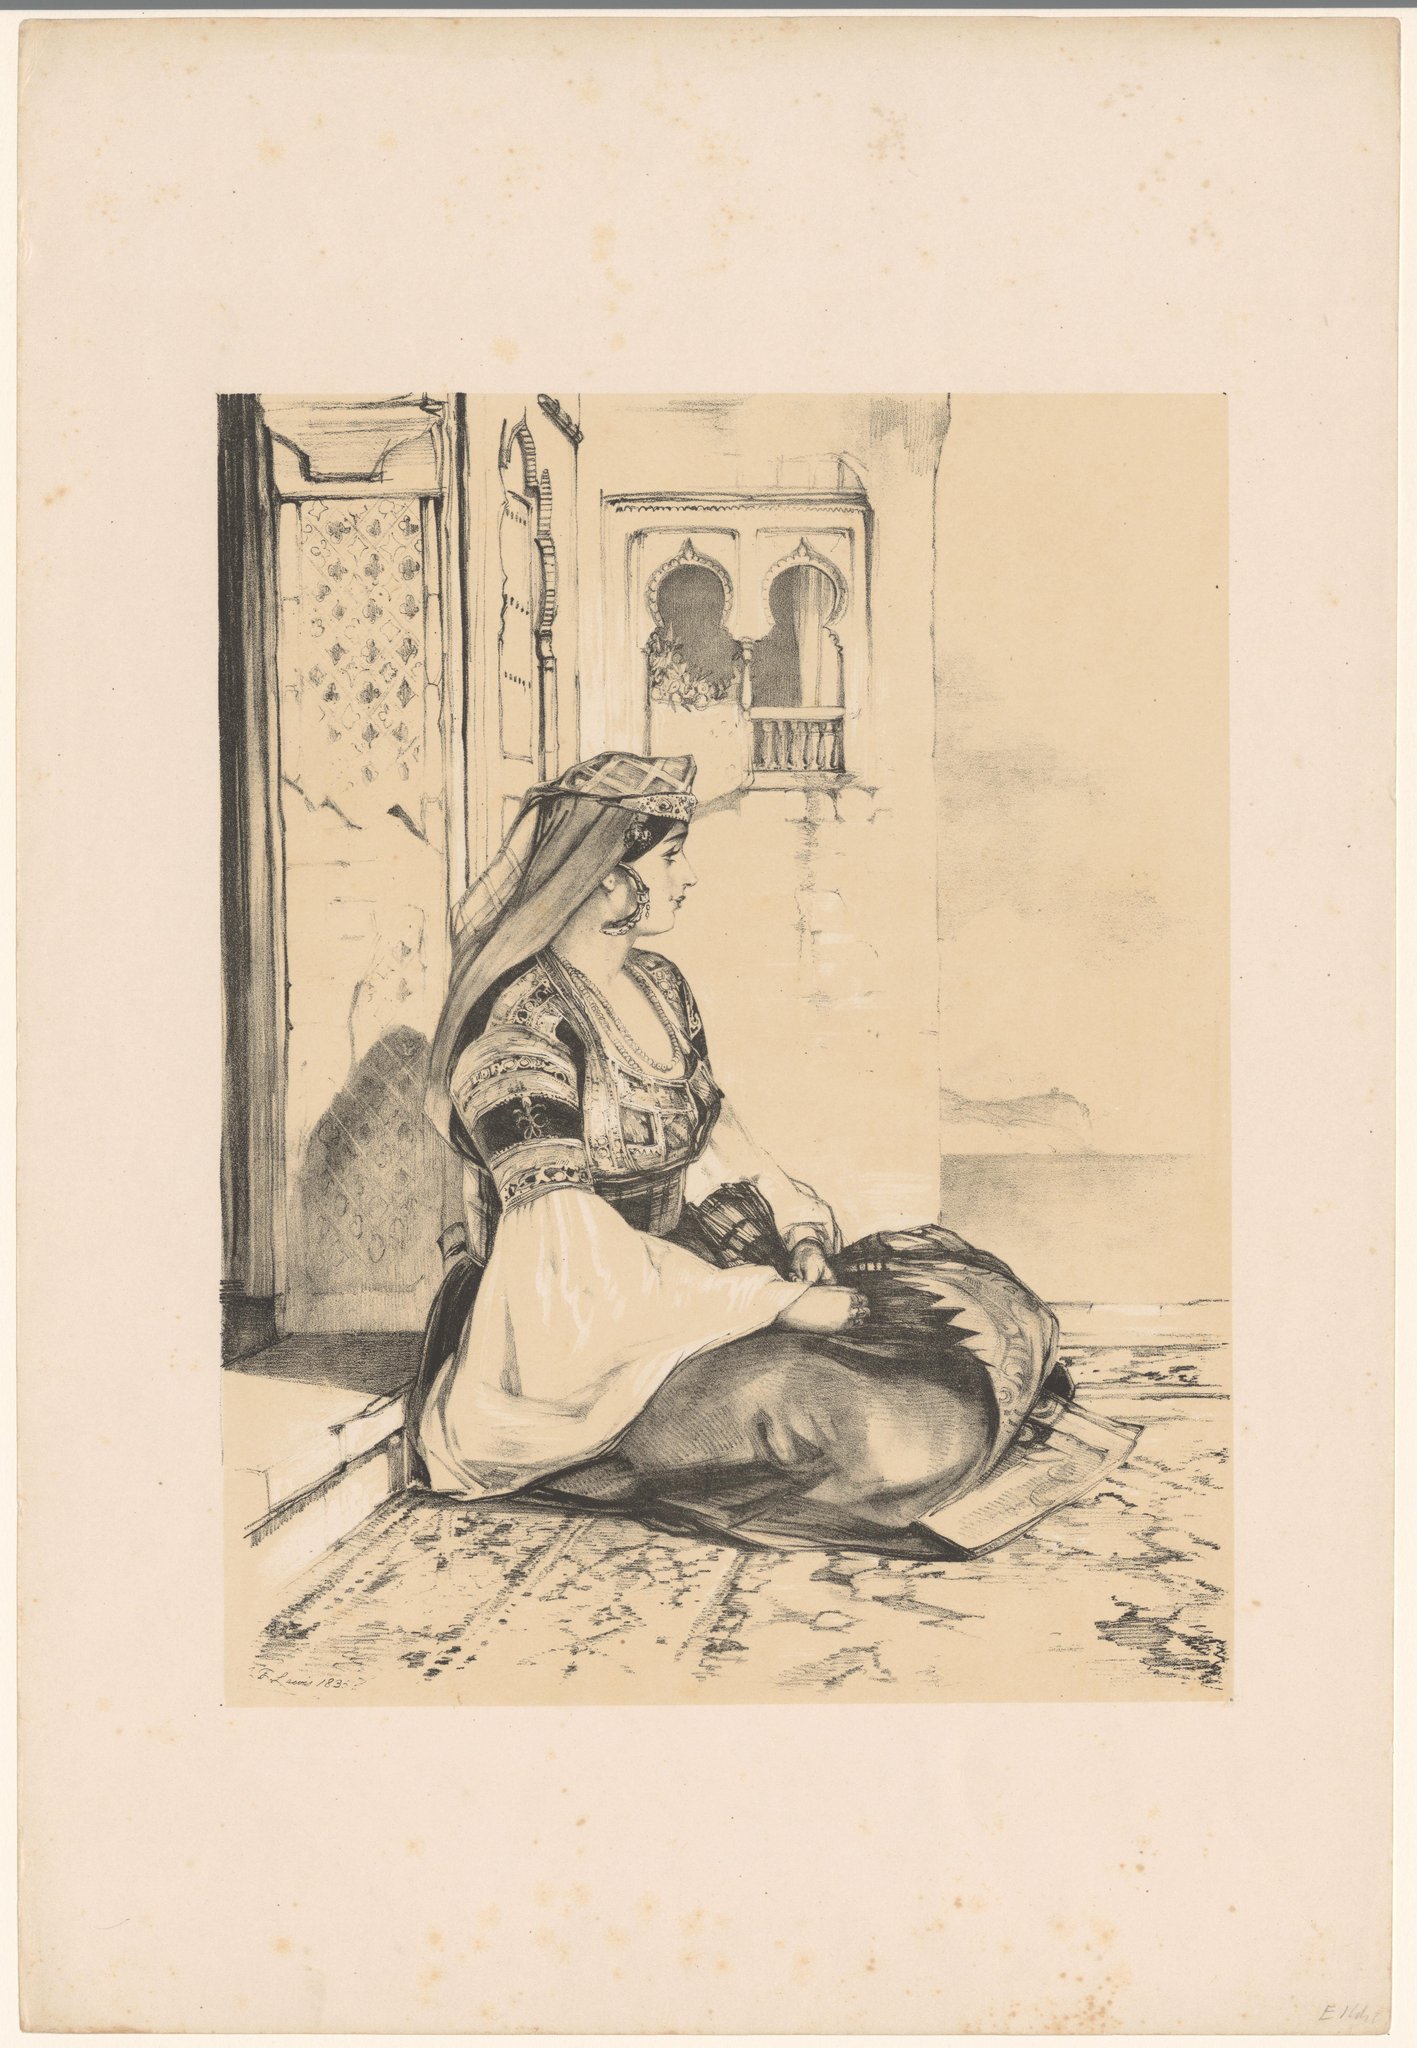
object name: print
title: Joodse vrouw uit Gibraltar in feestelijke kleding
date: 1836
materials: paper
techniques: tone lithography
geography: london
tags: adult woman, clothes for special purposes, sitting on the ground - aa - female human figure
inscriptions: collector's mark: Lugt 2228